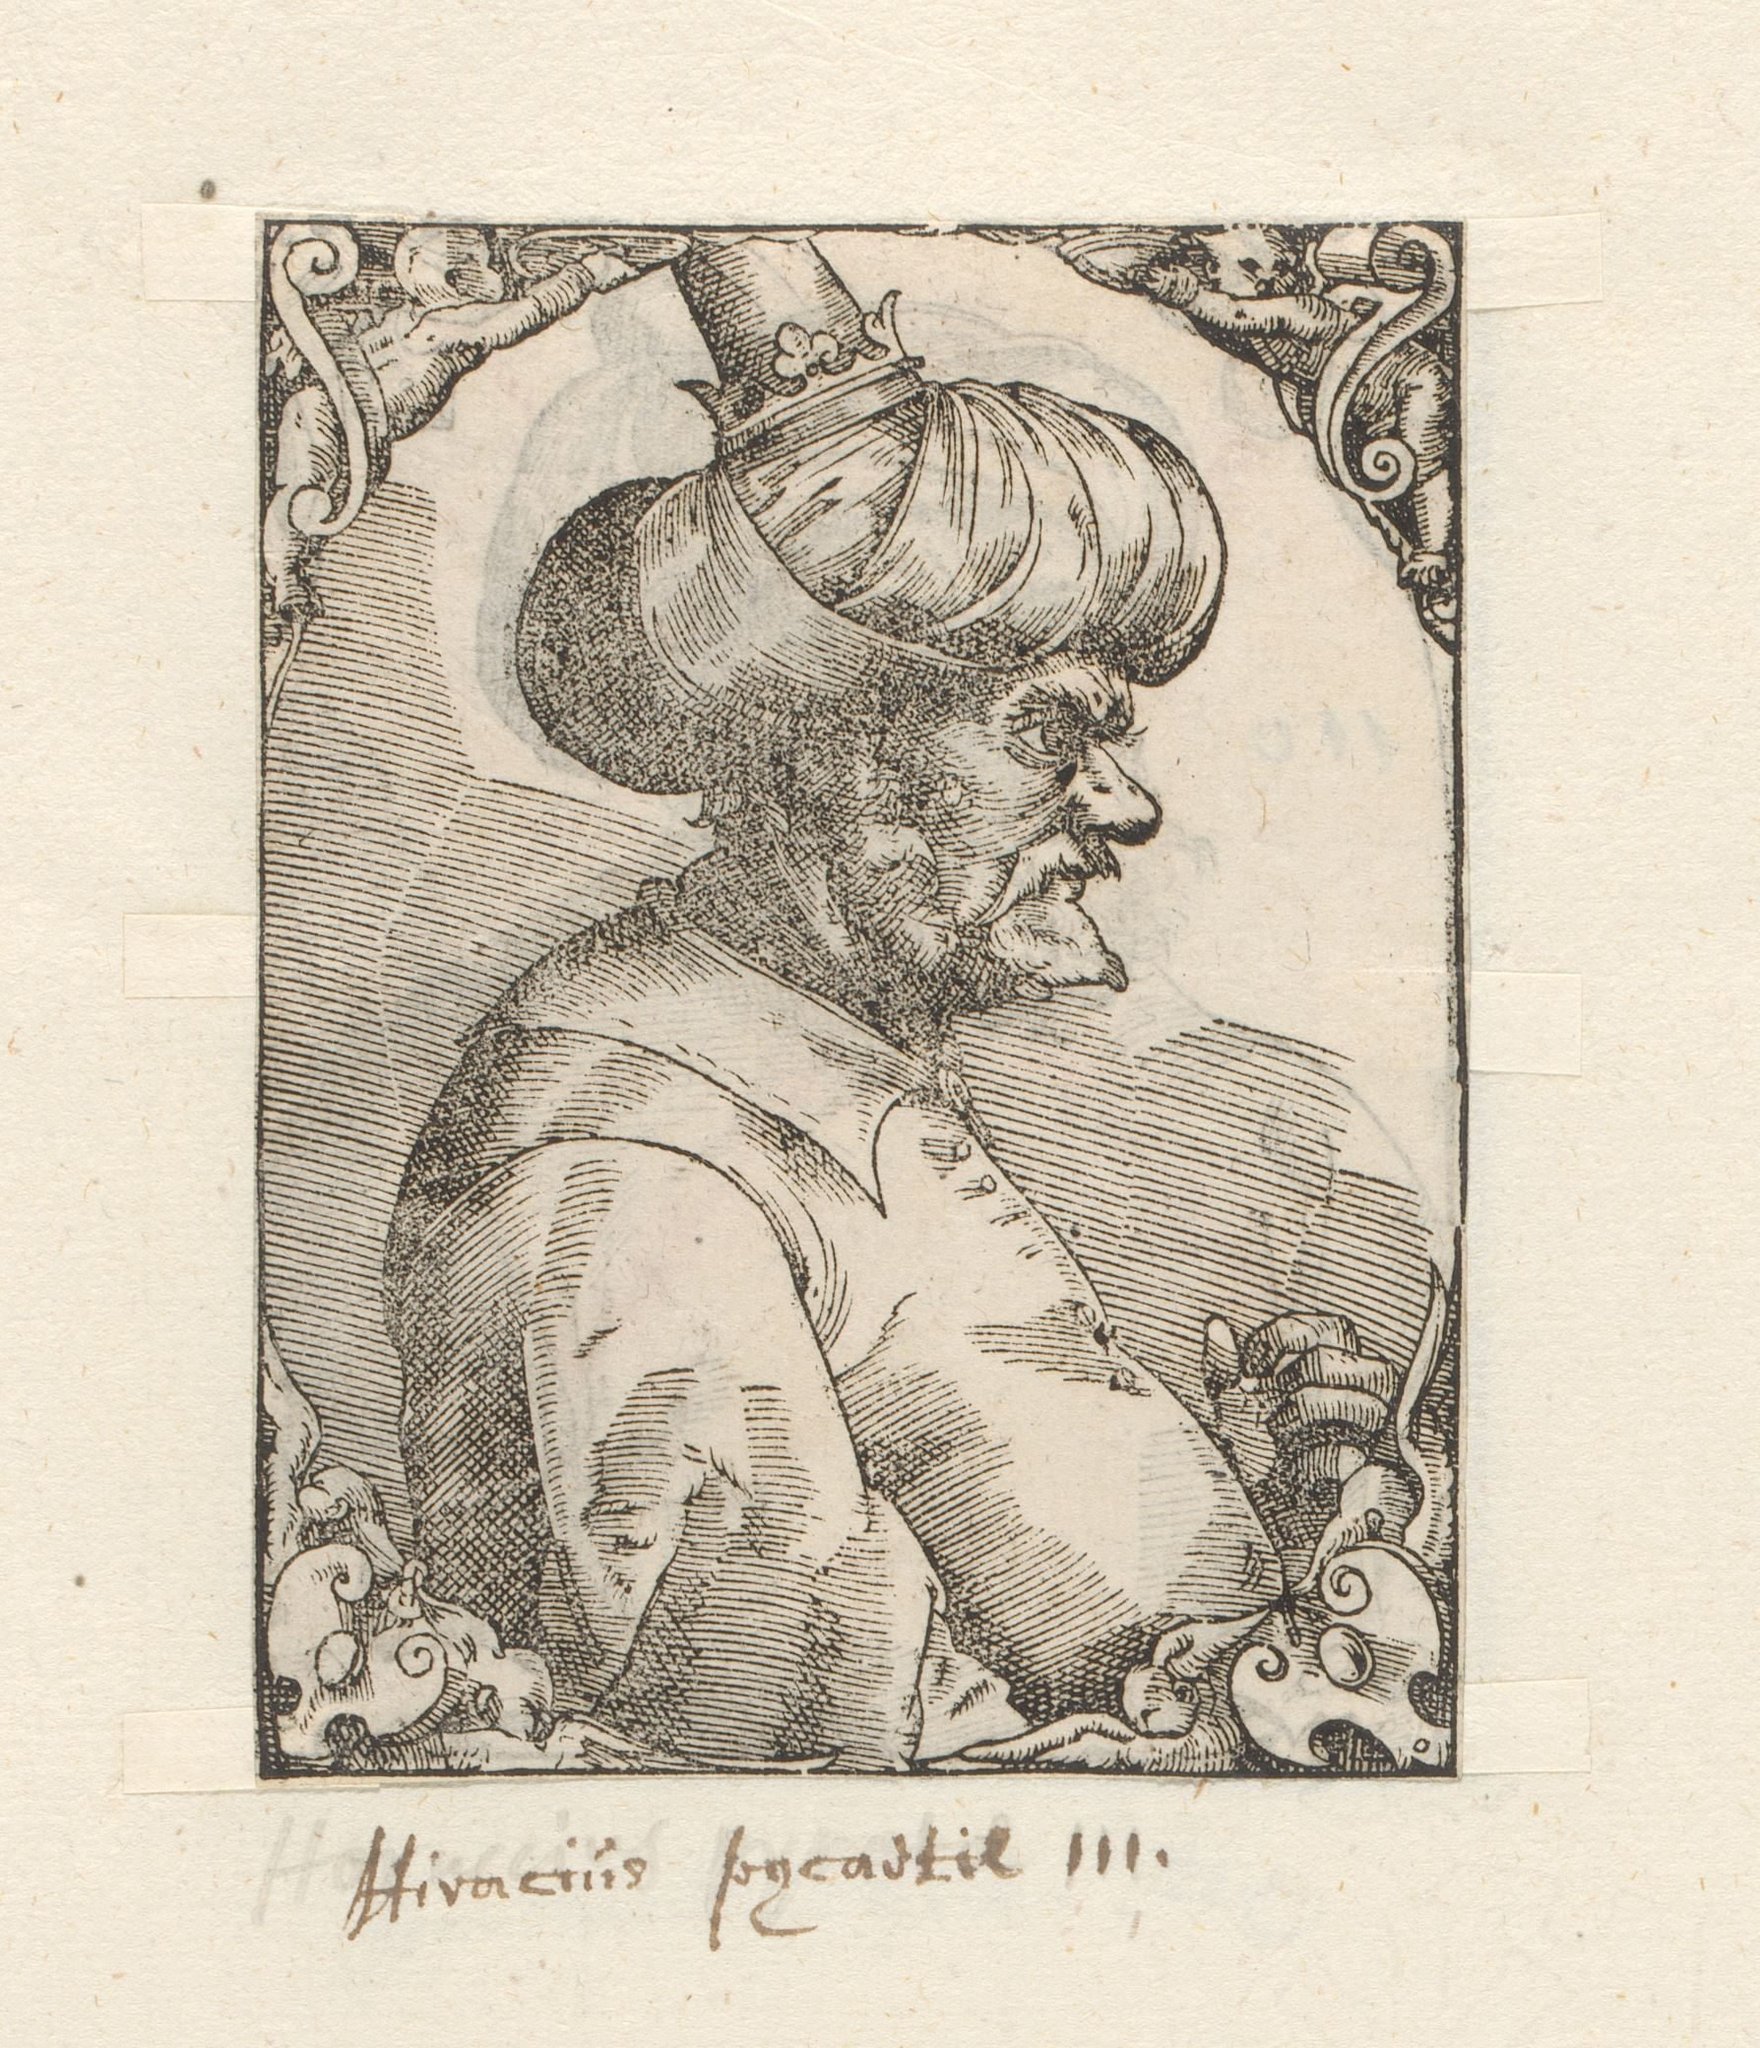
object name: album leaf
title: Portret van Horuccius Barbarosso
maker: Anonymous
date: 1549-1575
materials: paper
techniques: woodcut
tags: pirate, corsair, buccaneer, historical persons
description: Prent gebruikt in: Giovio, Paolo. Elogia Virorum bellica virtute illustrium (...). Bazel: Peter Perna, 1575.